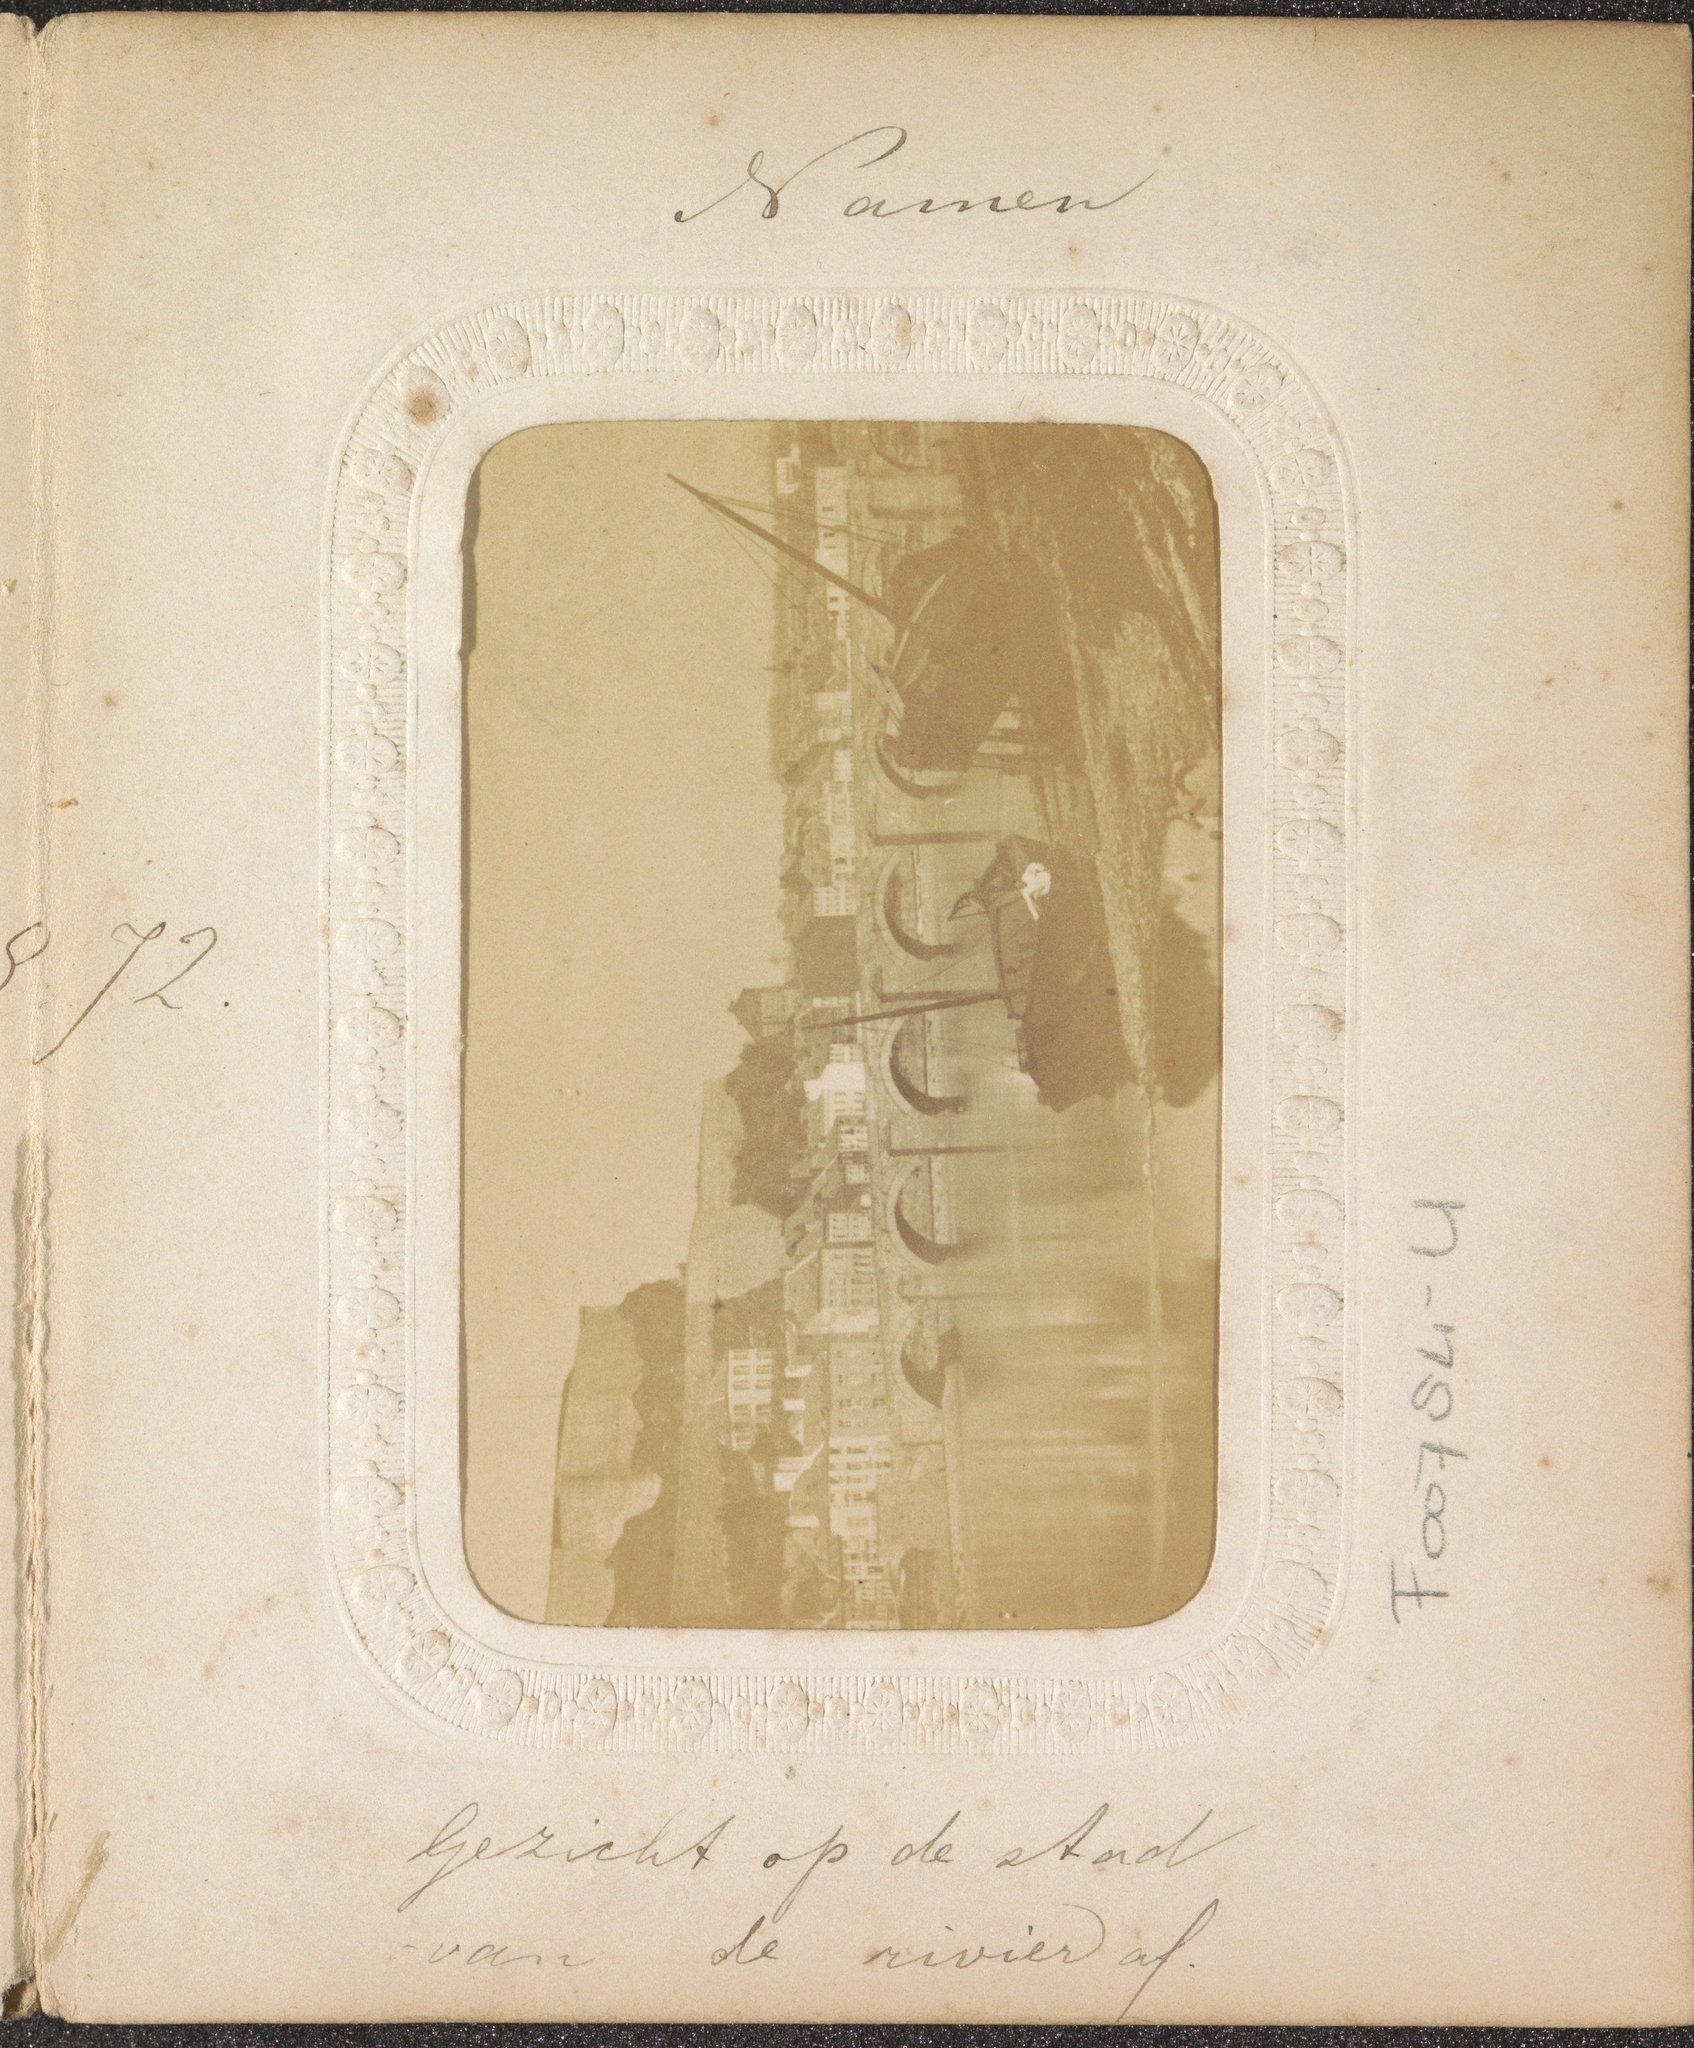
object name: photograph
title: Bords de la Meuse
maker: armand dandoy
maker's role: painter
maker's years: 1834-1898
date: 1872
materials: cardboard, paper, photographic support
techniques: albumen print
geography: namur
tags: fortified city, bridge in city across river, canal, etc., prospect of city, town panorama, silhouette of city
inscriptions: name: ‘EdV’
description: Onderdeel van Fotoalbum met bezienswaardigheden in Nederlandse, Belgische en Duitse steden.